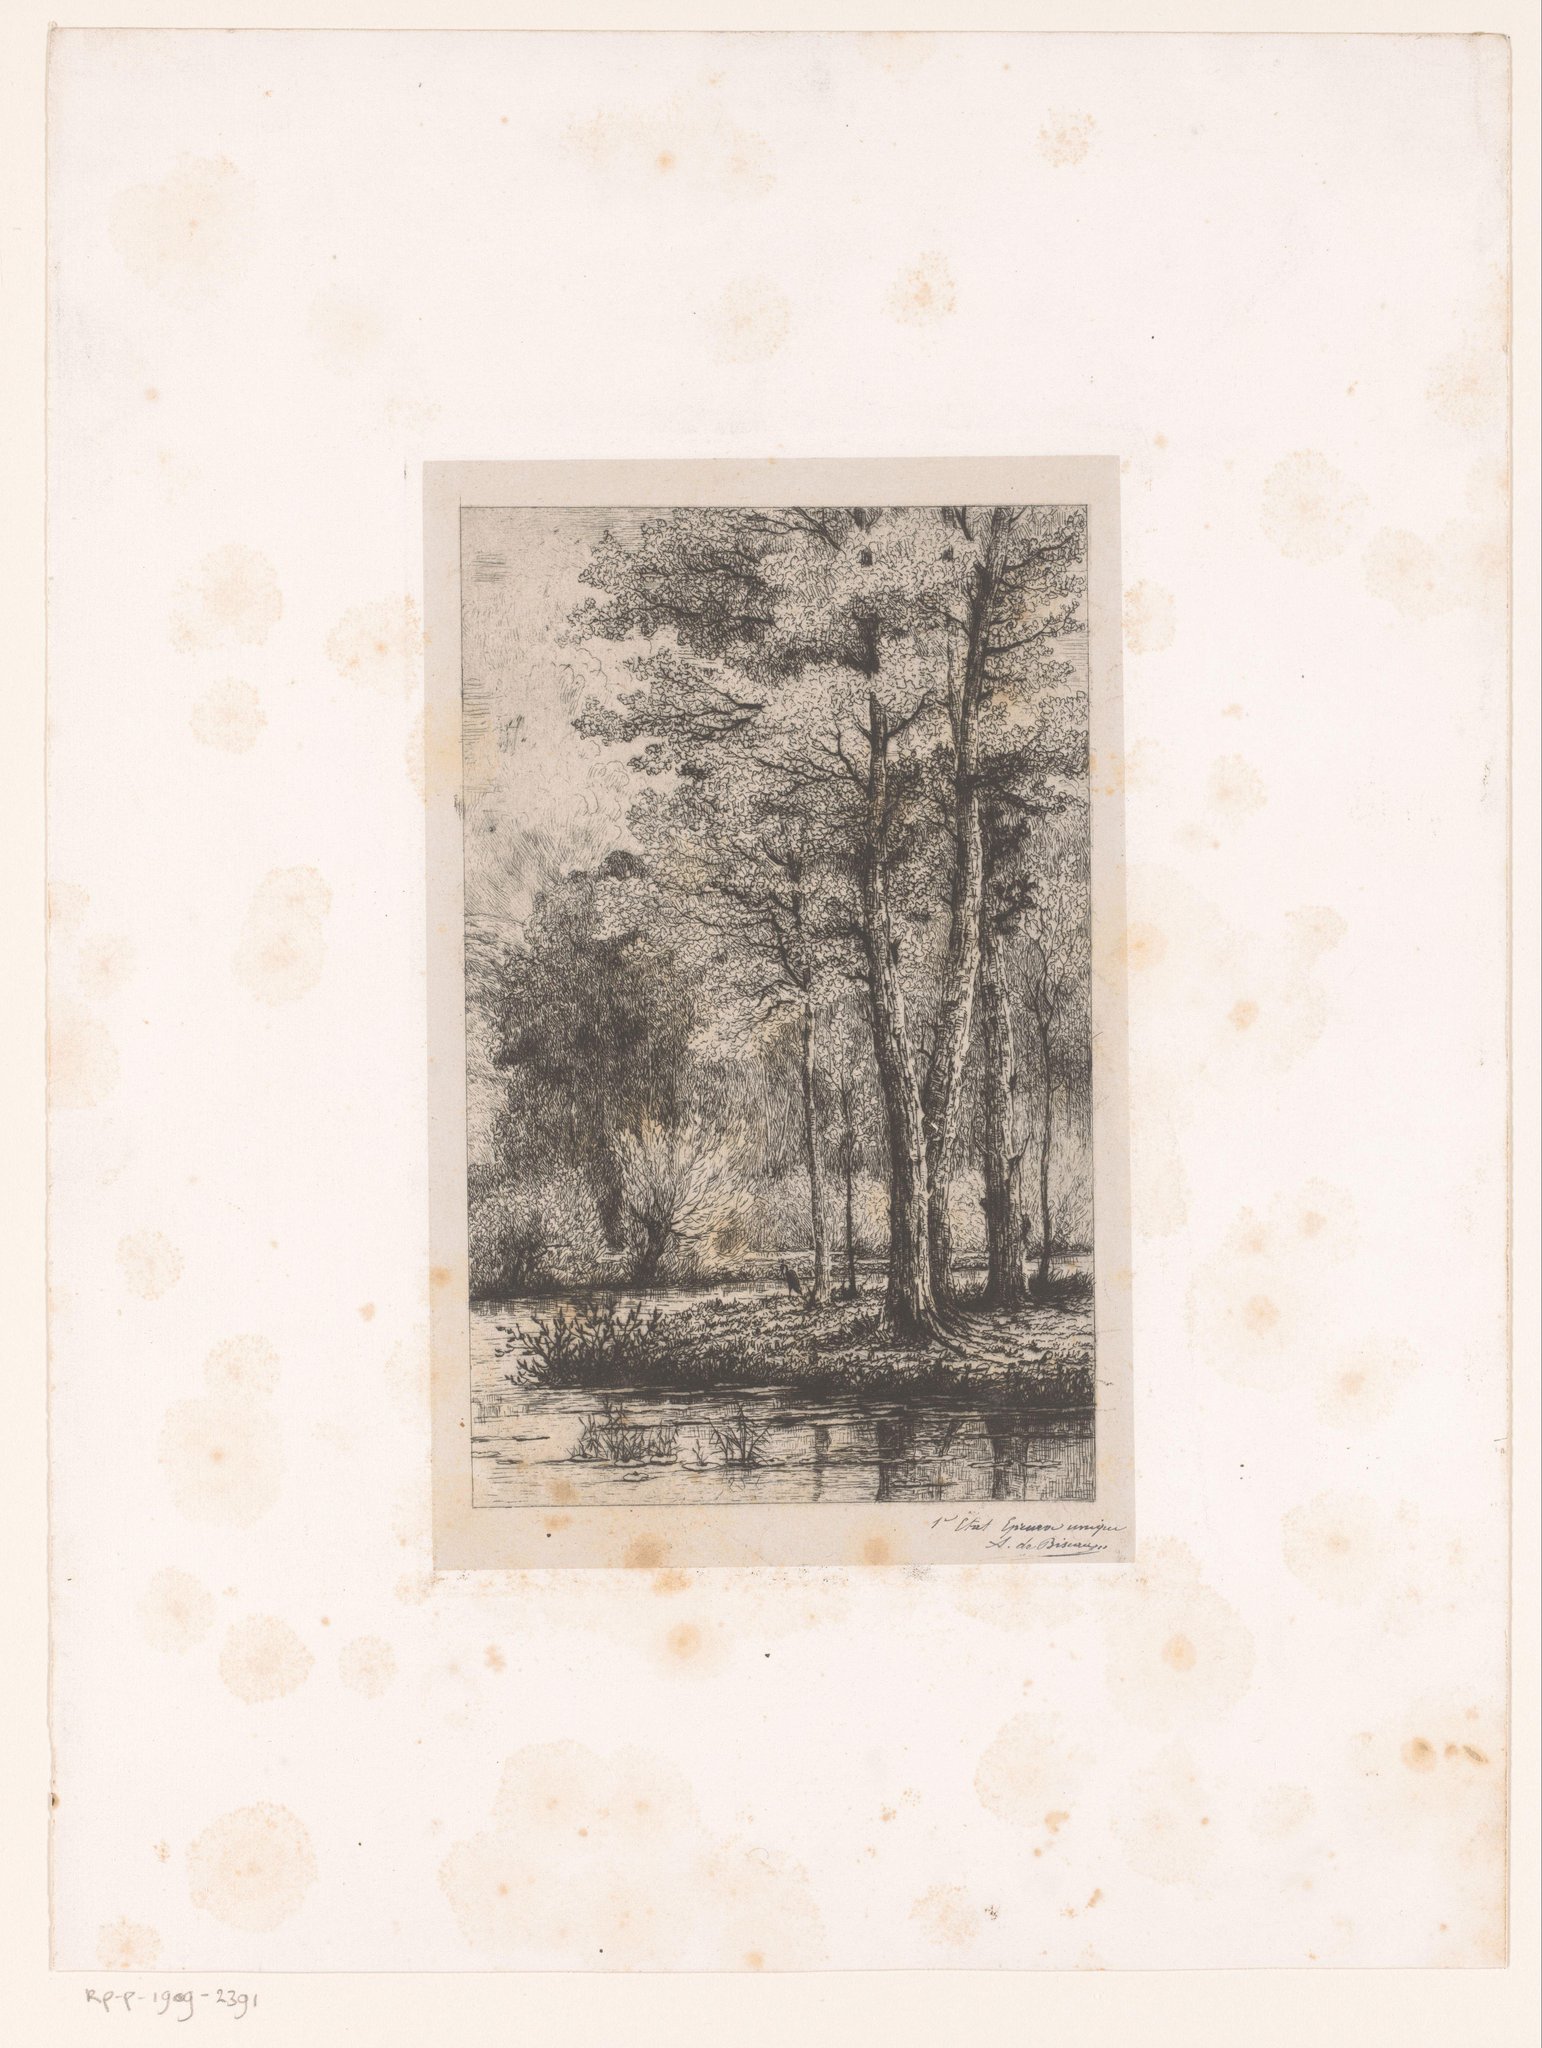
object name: print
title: Bomen aan het water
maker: aristide de biseau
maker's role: print maker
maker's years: 1844-1883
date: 1875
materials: paper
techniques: etching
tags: trees, landscapes, shore-birds and wading-birds: heron, pond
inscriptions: inscription: ‘1e Etat Epreuve unique’, collector's mark: Lugt 2228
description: Een latere staat van deze prent is gebruikt in: Album du Journal des Beaux-Arts. Antwerpen, s.n., 1875.